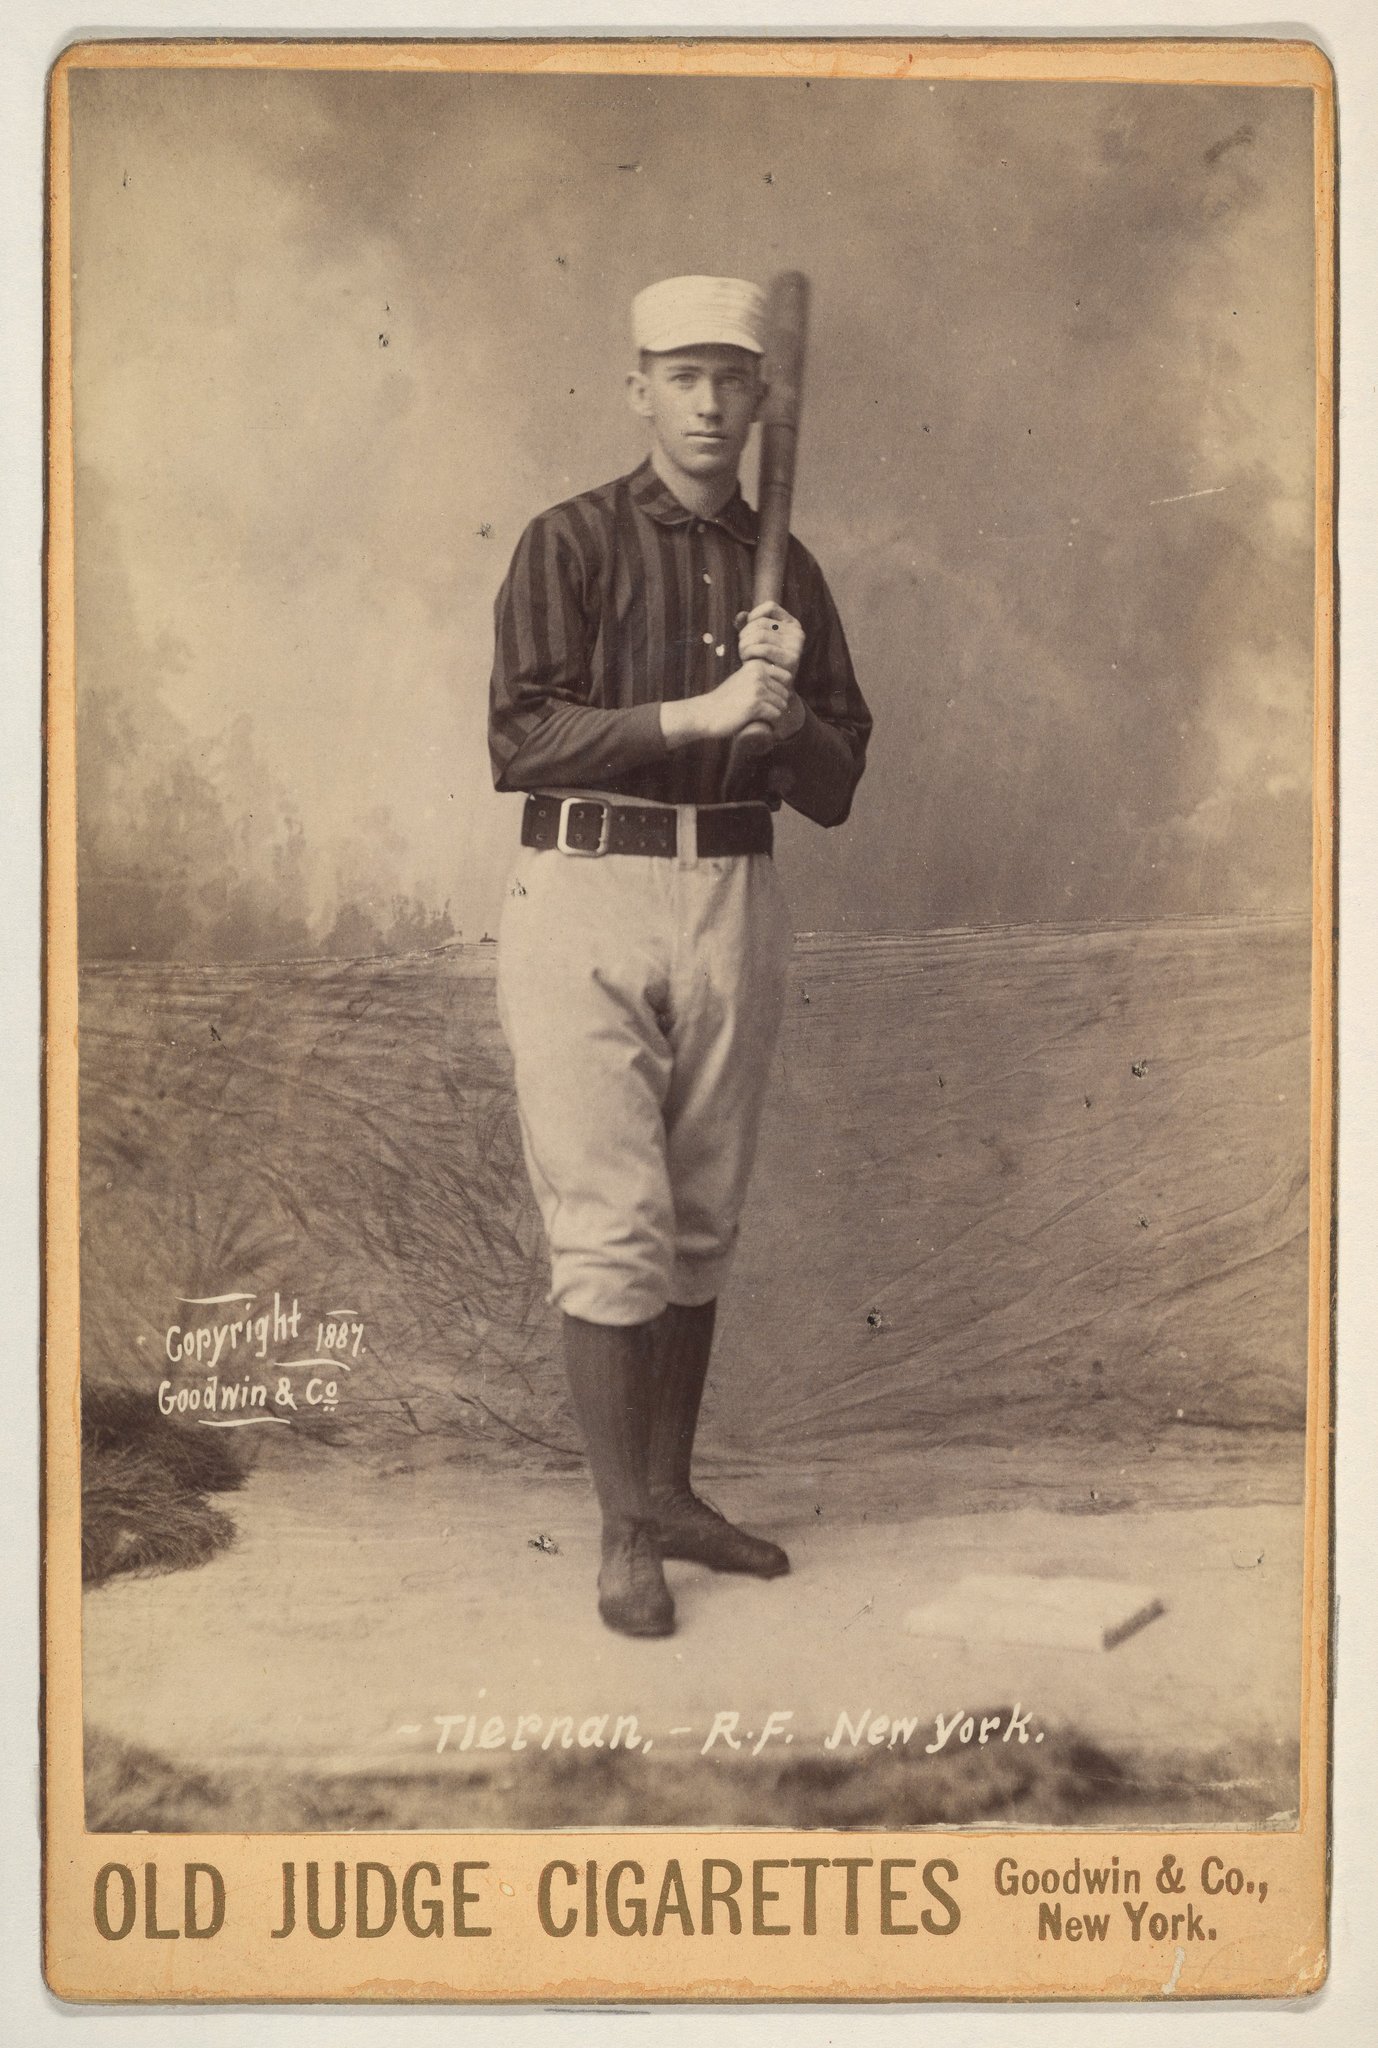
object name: baseball card, photograph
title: Tiernan, Right Field, New York, from the series Old Judge Cigarettes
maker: goodwin & company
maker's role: publisher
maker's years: 1850-1950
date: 1887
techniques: albumen silver print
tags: men,portraits,baseball,athletes